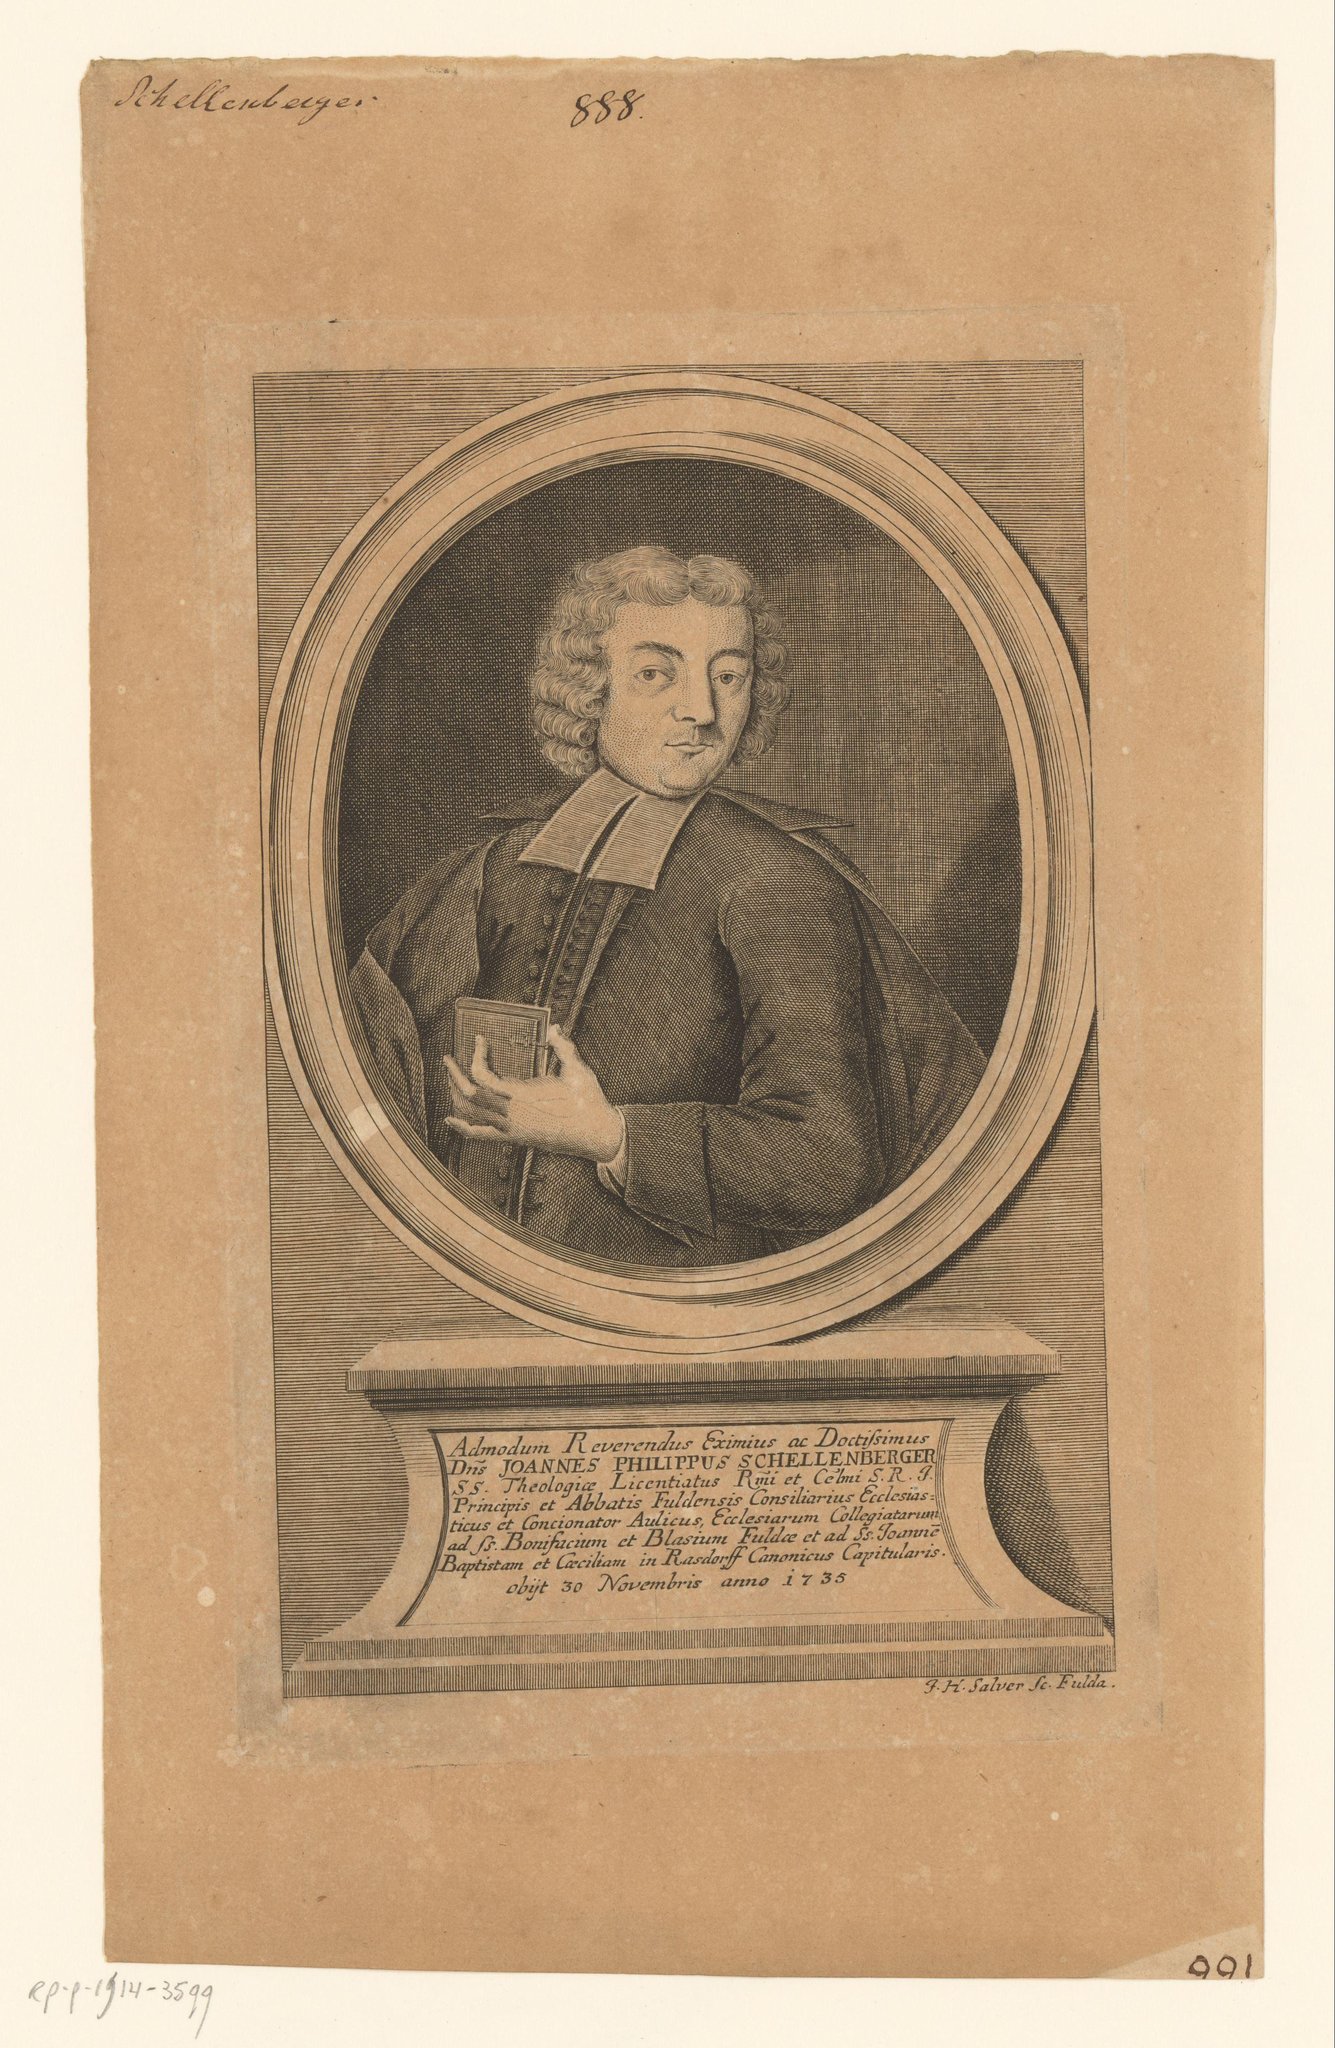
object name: print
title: Portret van Johann Philip Schellenberg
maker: johan h. salver (ii)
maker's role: print maker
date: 1735-1799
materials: paper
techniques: engraving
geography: fulda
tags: theologian, historical persons, book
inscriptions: collector's mark: Lugt 2228